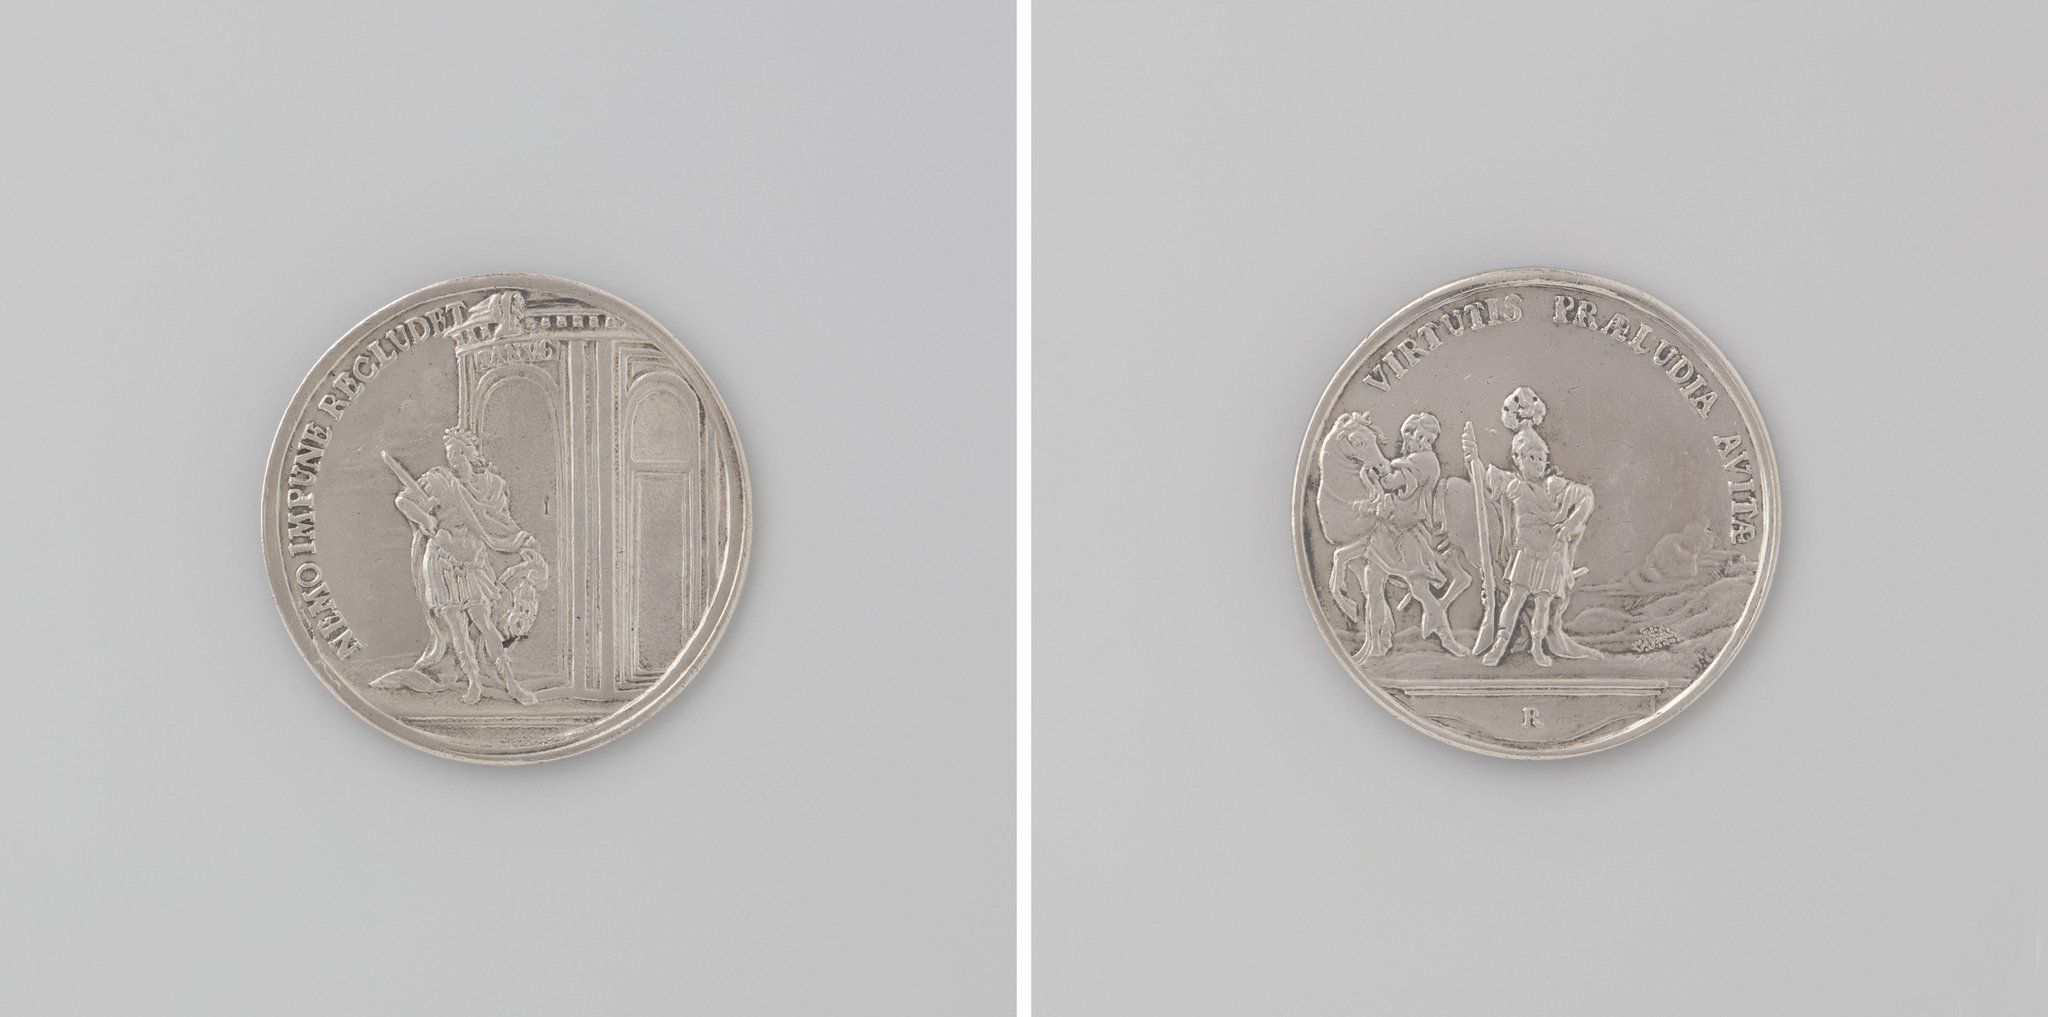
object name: jeton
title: Vrede van Rijswijk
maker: philippe roëttiers (ii)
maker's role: medailleur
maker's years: 1640-1718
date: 1697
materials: silver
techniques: striking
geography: antwerp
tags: maximiliaan ii emanuel (keurvorst van beieren)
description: Zilveren penning. Voorzijde: keurvorst van Beieren, in Romeinse kledij staande naast de door hem gesloten tempel van Janus binnen omschrift. Keerzijde: jonge keurprins in Romeinse kledij, leunend op geweer; naast hem knecht met zijn paard binnen omschrift